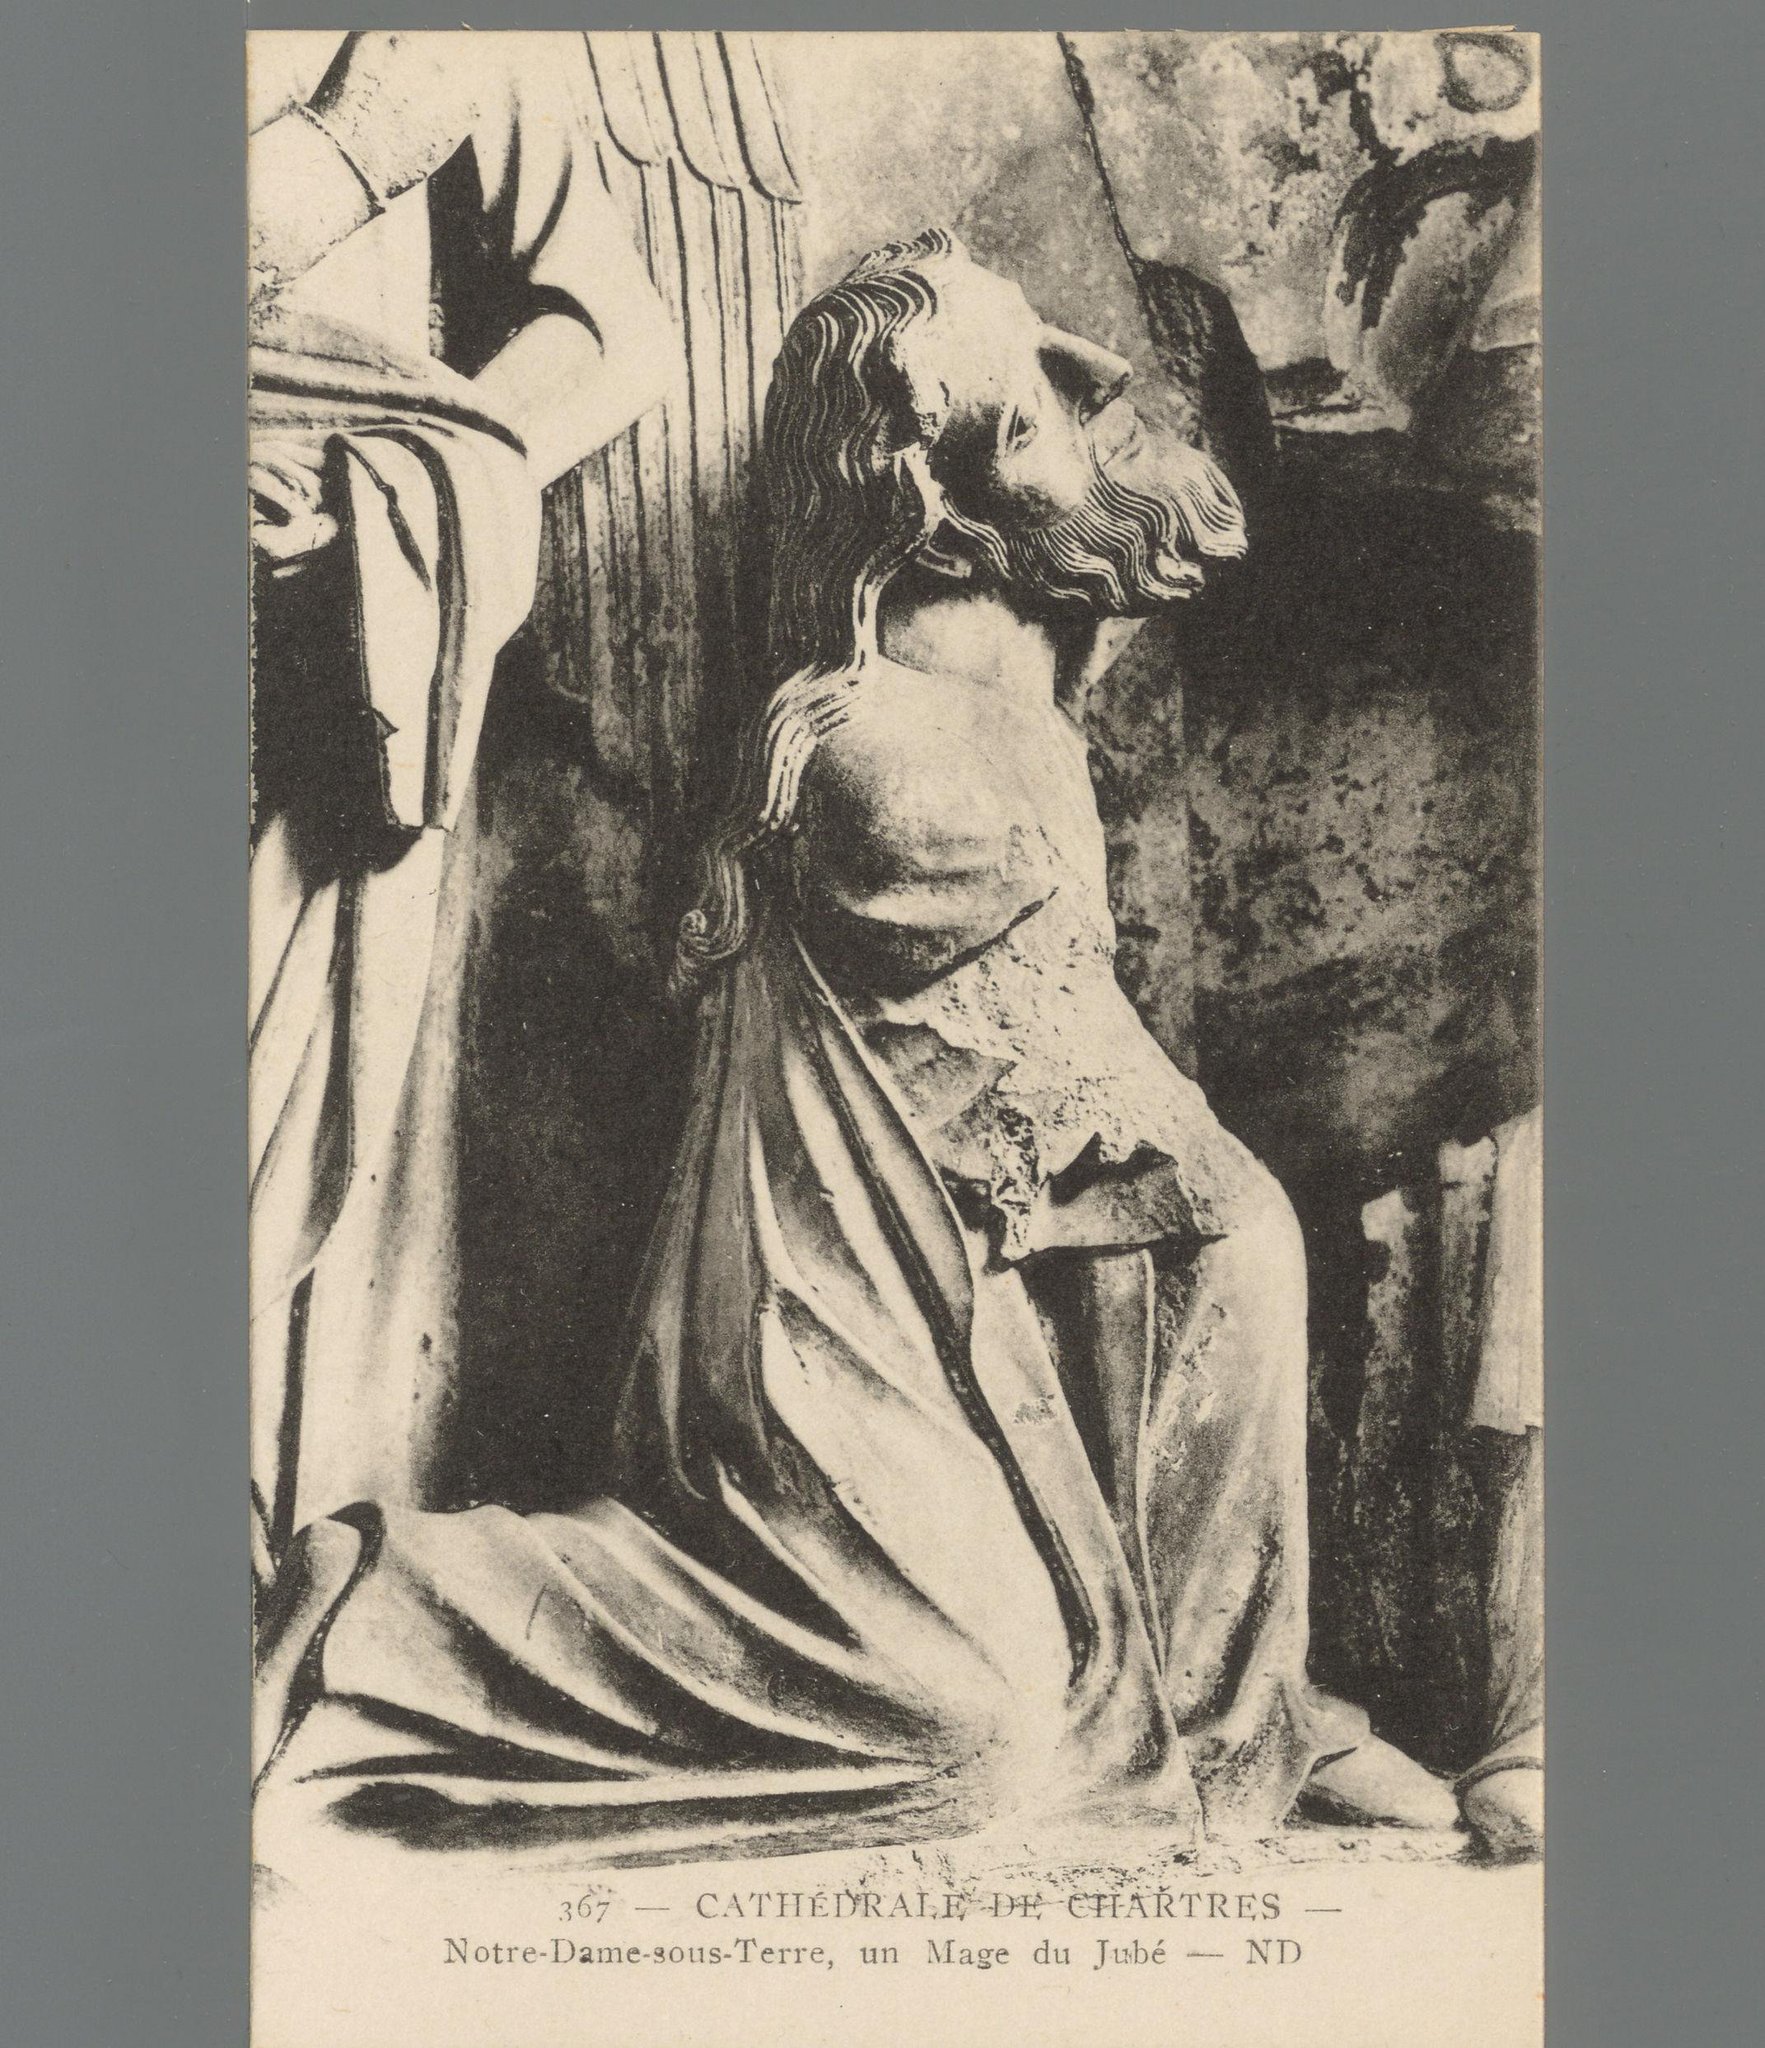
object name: photomechanical print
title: Cathédrale de Chartres - Notre-Dame-sous-Terre, un mage du Jubé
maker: Anonymous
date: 1903-1932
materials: cardboard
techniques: photograph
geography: paris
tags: church (exterior), statues, paintings, etc. ~ objects of worship in roman religion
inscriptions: collector's mark: ‘AFE v S’